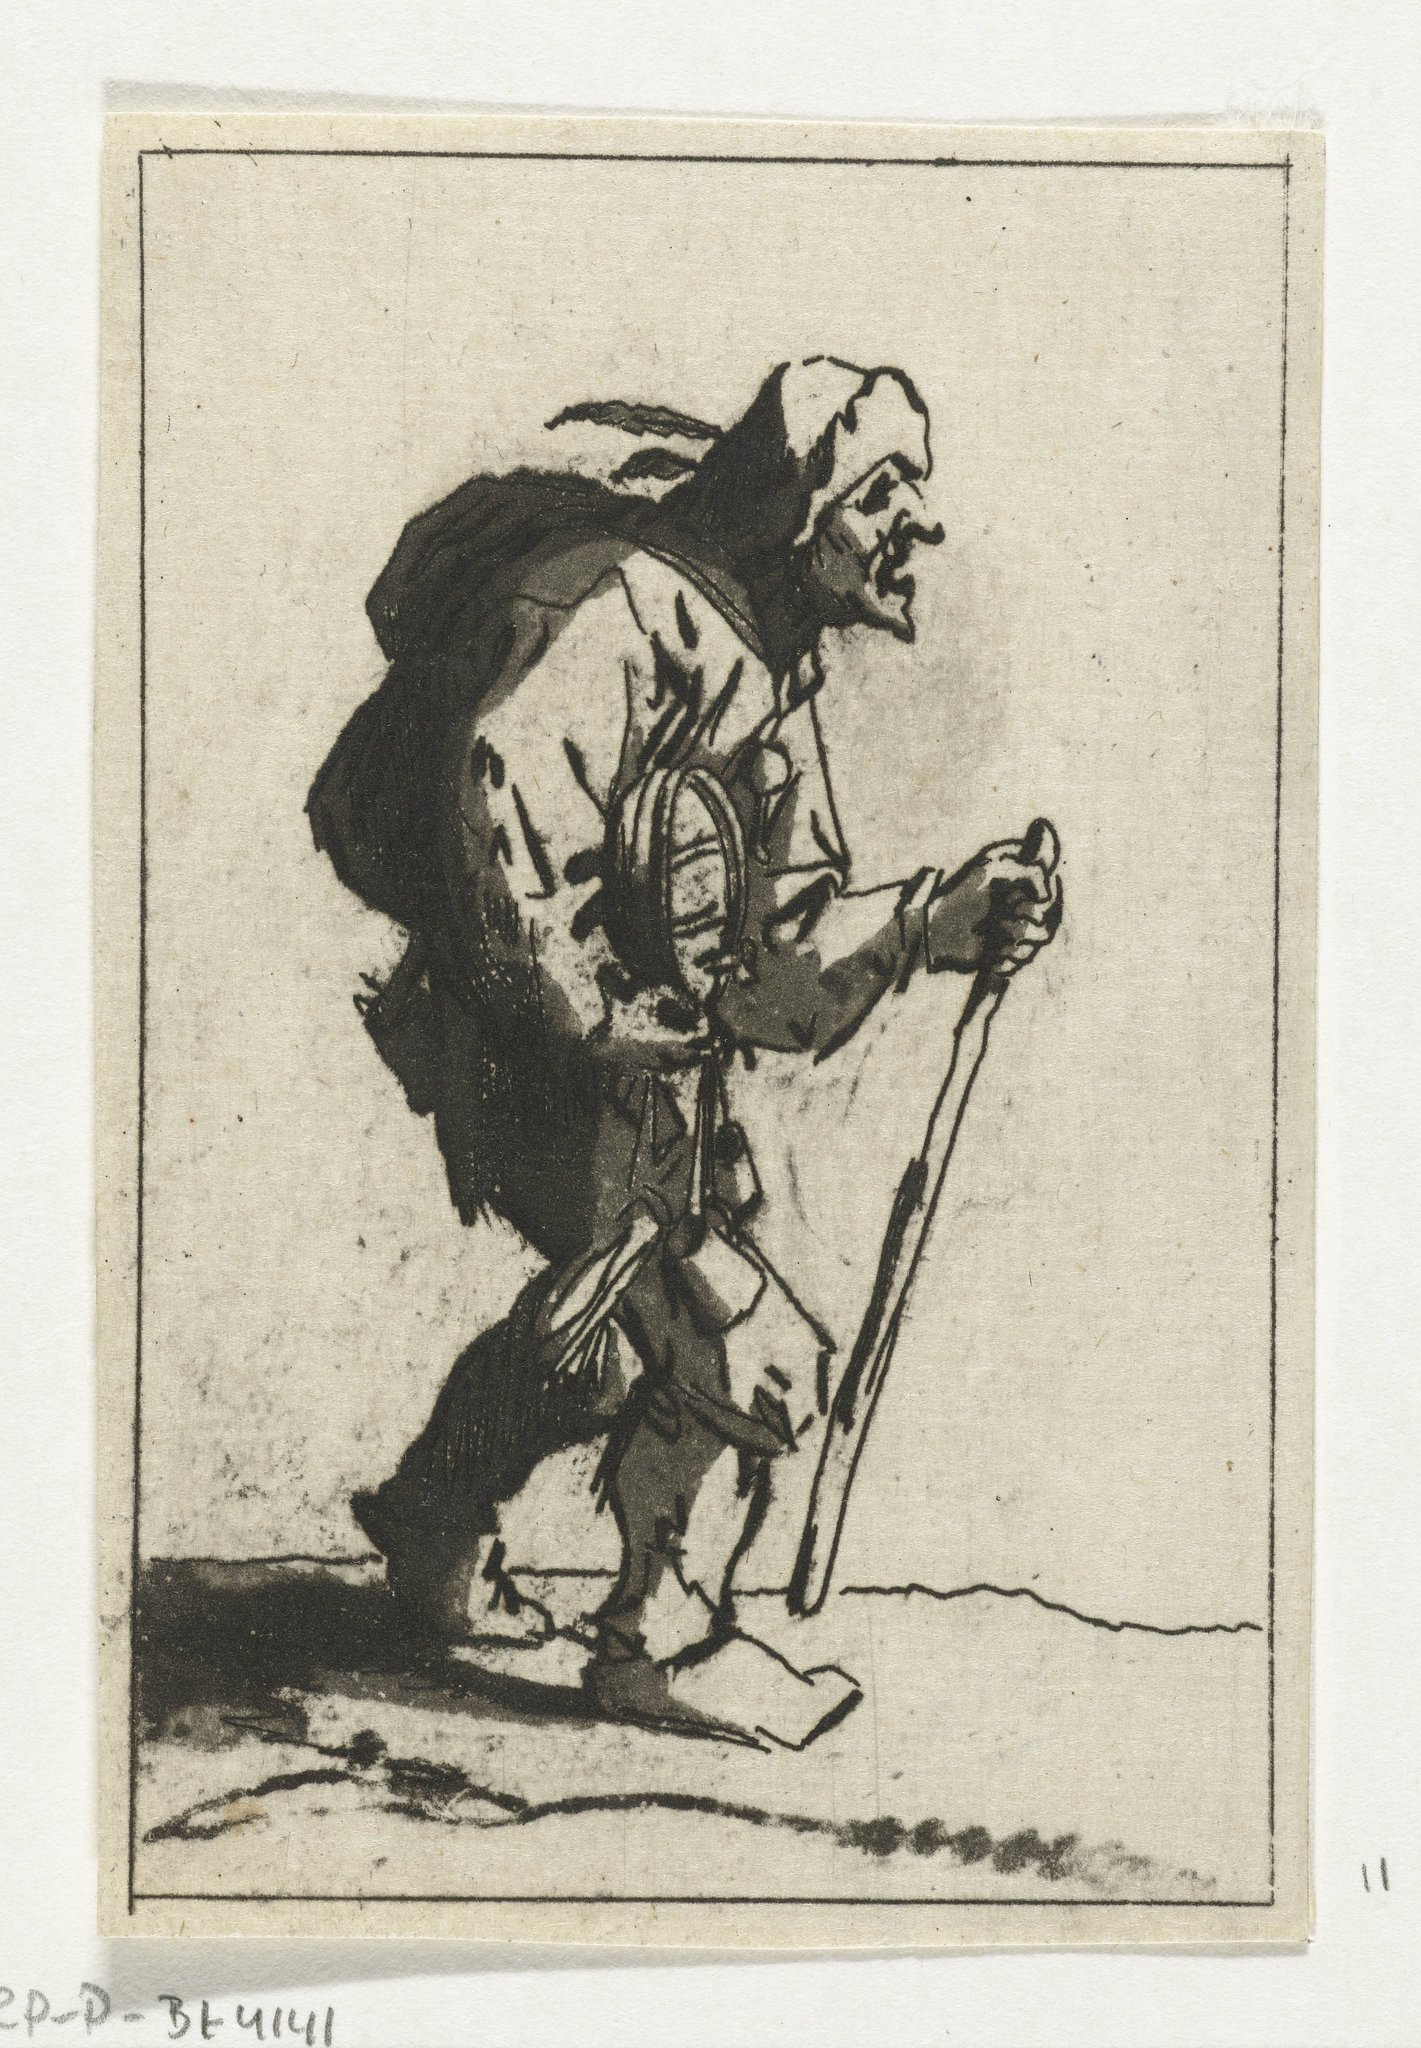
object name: print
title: Inkt- en pennenkoopman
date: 1778-1838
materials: paper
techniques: aquatint, etching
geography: netherlands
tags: ink-well, street-trader, beggar, pencil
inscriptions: collector's mark: Lugt 2228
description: Een koopman lopend met een stok in zijn hand. Hij heeft een vaatje onder zijn rechterarm, en houdt met zijn rechterhand inktkokers en pennen vast, die aan een koord hangen.